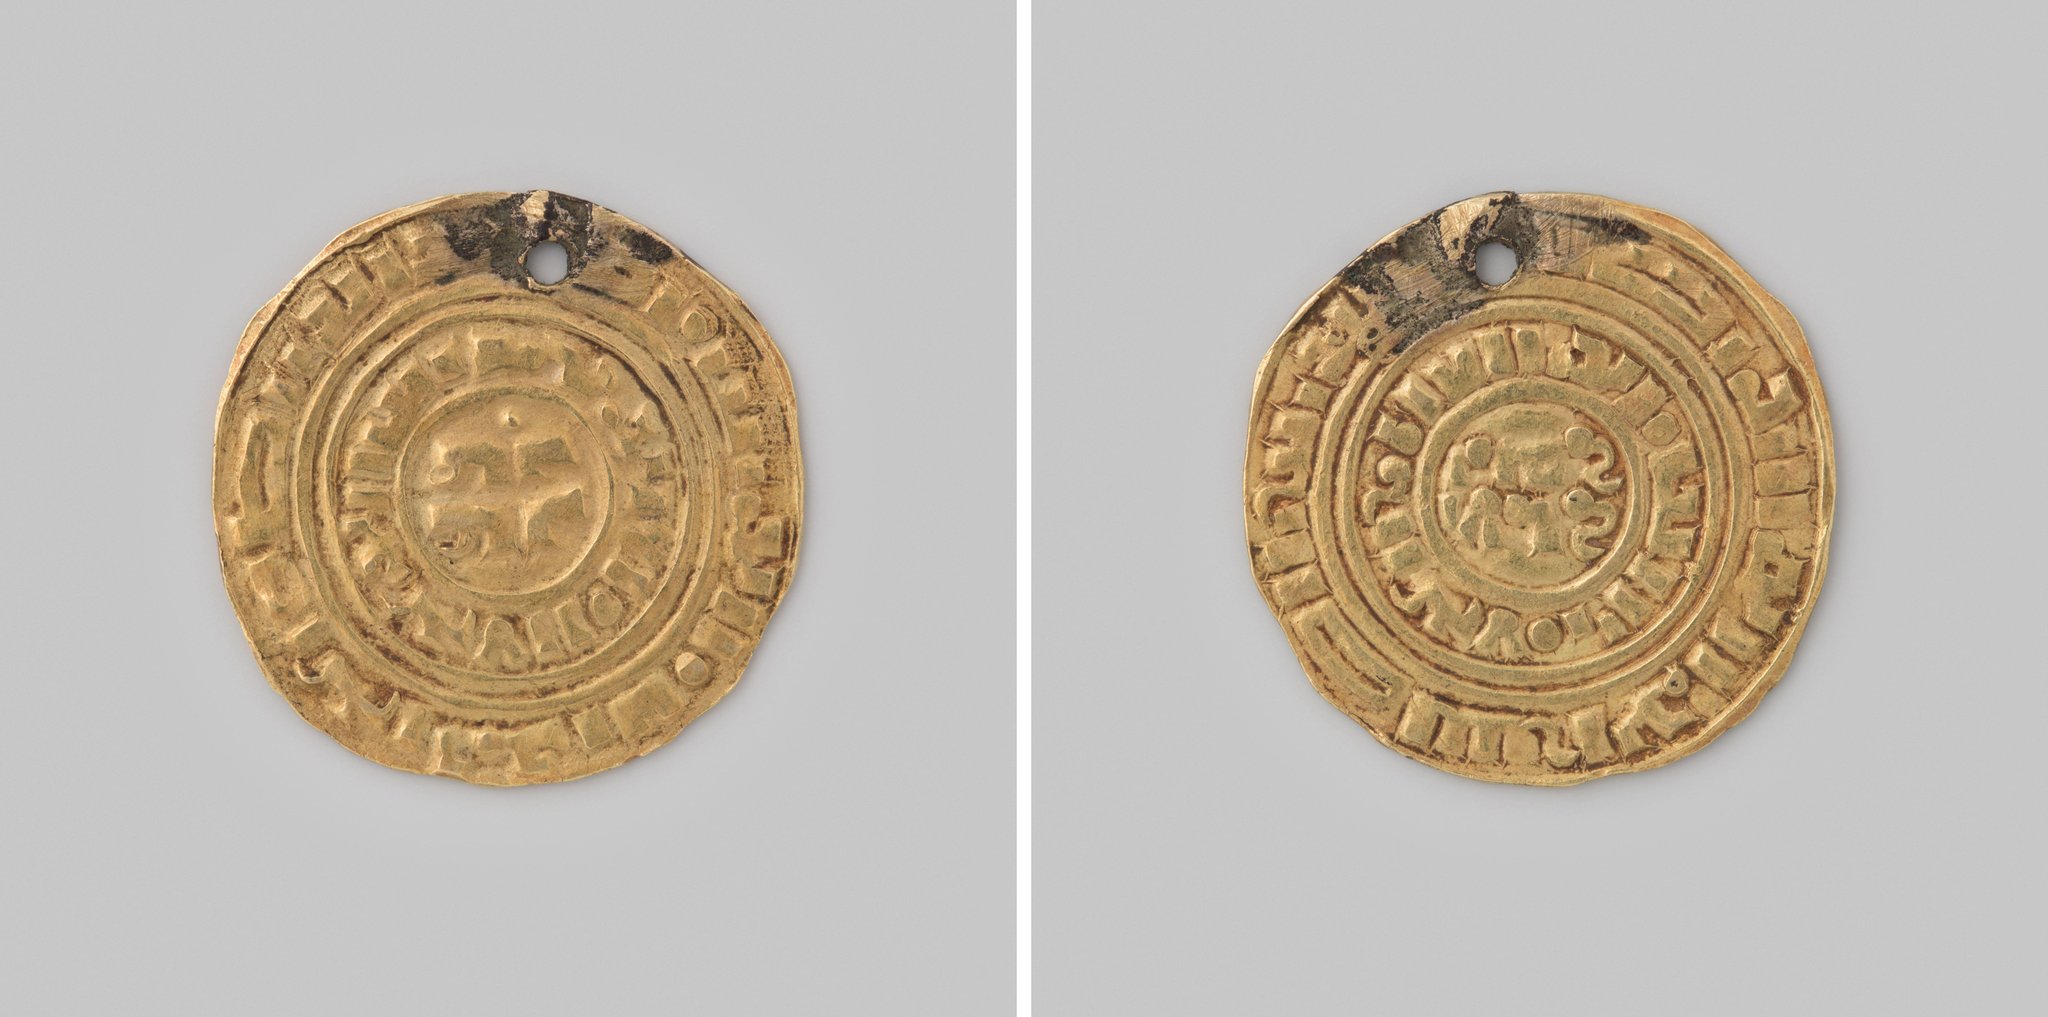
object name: besant sarracenatus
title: Besant sarracenatus of dinar soeri van de Kruisvaarders, 1101-1129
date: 1101-1129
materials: gold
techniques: striking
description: Gouden munt. Voorzijde: binnen cirkel opschrift in Arabische lettertekens in twee regels. Rodom cirkel dubbel omschrift in Arabische lettertekens. Keerzijde: binnen cirkel opschrift in Arabische lettertekens in twee regels. Rondom cirkel dubbel omschrift in Arabische lettertekensin twee regels. Door Italiaanse bankiers vervaardigde nabootsing van de dinar van el-Amir bi-akhami ïllah, 1101-1129. In muntplaatje is later gat aangebracht om de munt als sieraad te dragen. Het woord besant is een verbastering van Byzanthium en verwijst naar de Byzanthijnse gouden solidi. Sar[r]asenatus verwijst naar de Saracenen.